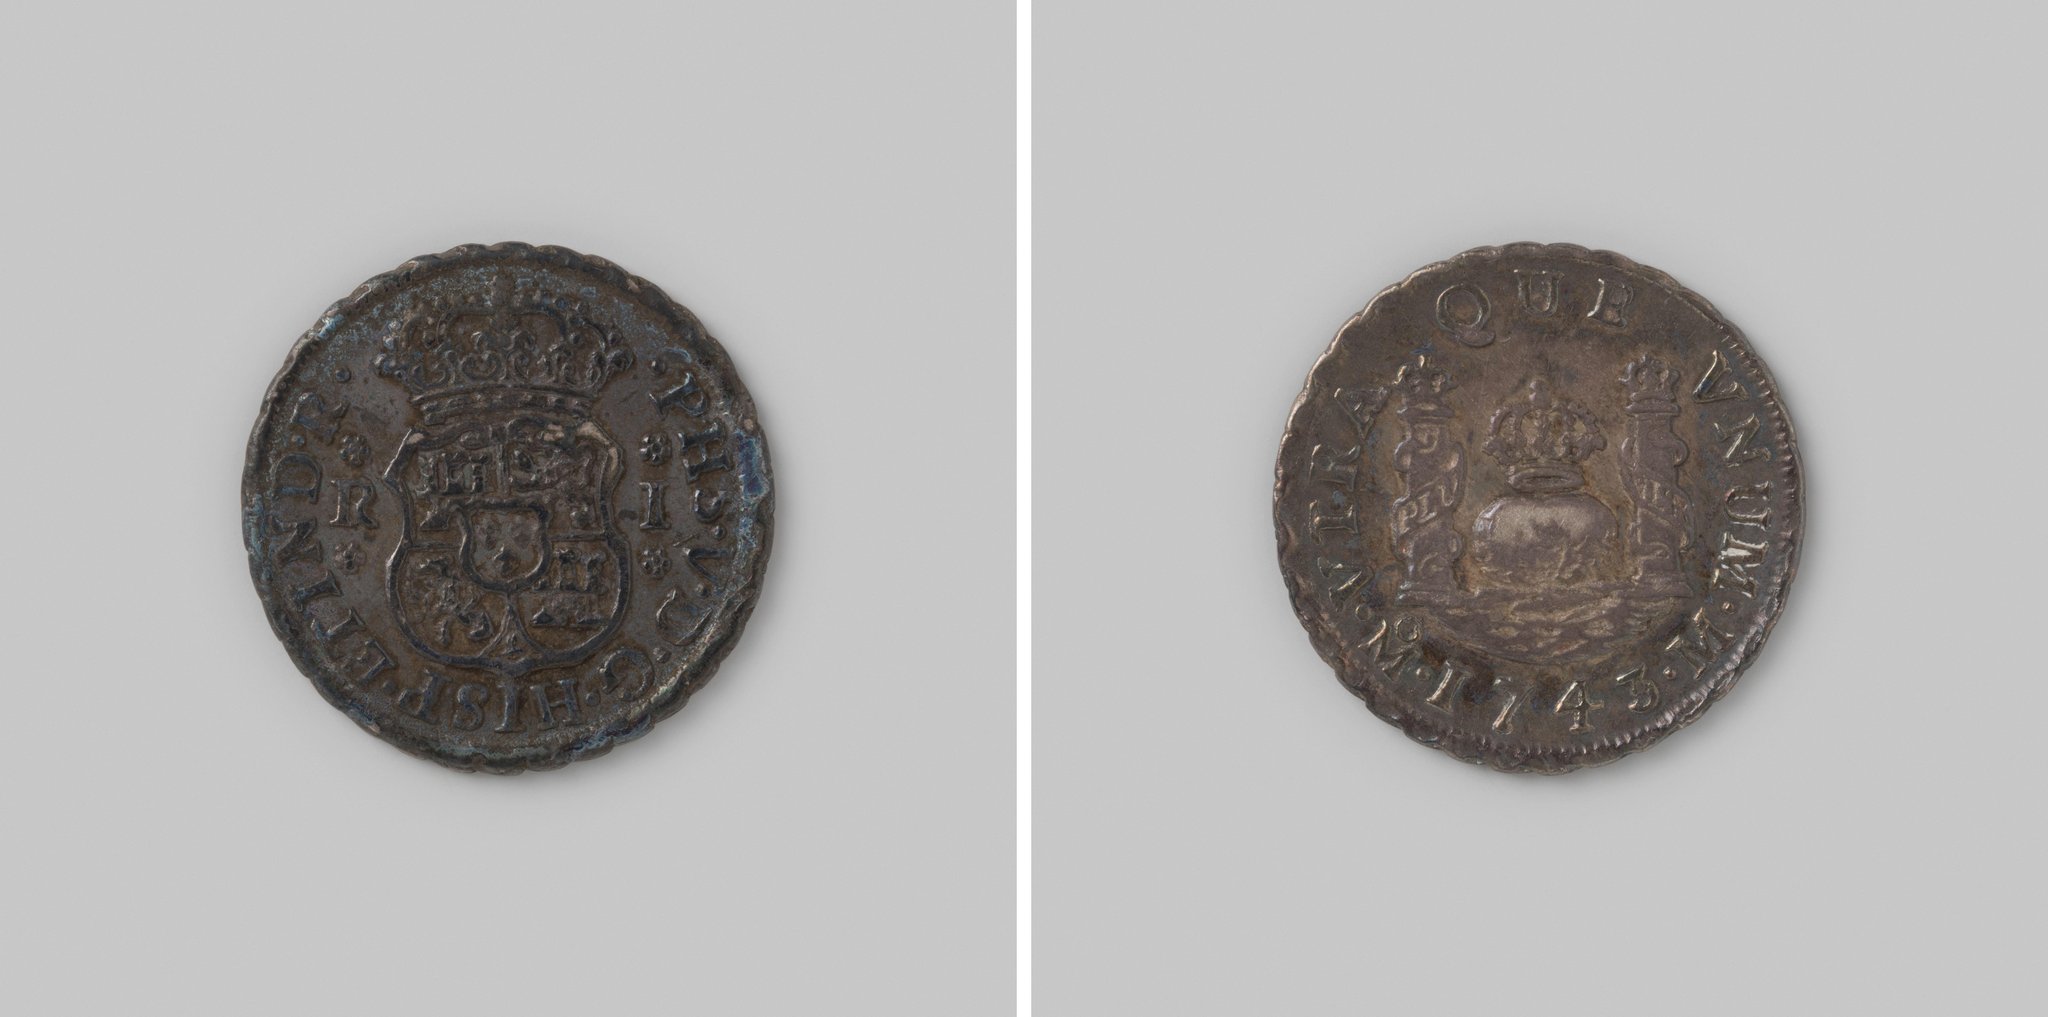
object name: real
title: Mexico, koning Philips V, reaal, 1743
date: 1743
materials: silver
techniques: striking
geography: mexico city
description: Zilveren munt. Voorzijde: tussen waarde-aanduiding: R 1 gekroond samengesteld wapenschild. Keerzijde: tussen twee uit zee oprijzende gekroonde zuilen, waarop banderol met opschrift, twee in elkaar grijpende wereldbollen, waarboven kroon. Jaartal onderaan in omschrift. Links daarvan muntplaats-aanduiding: Mo. Bloemrand.